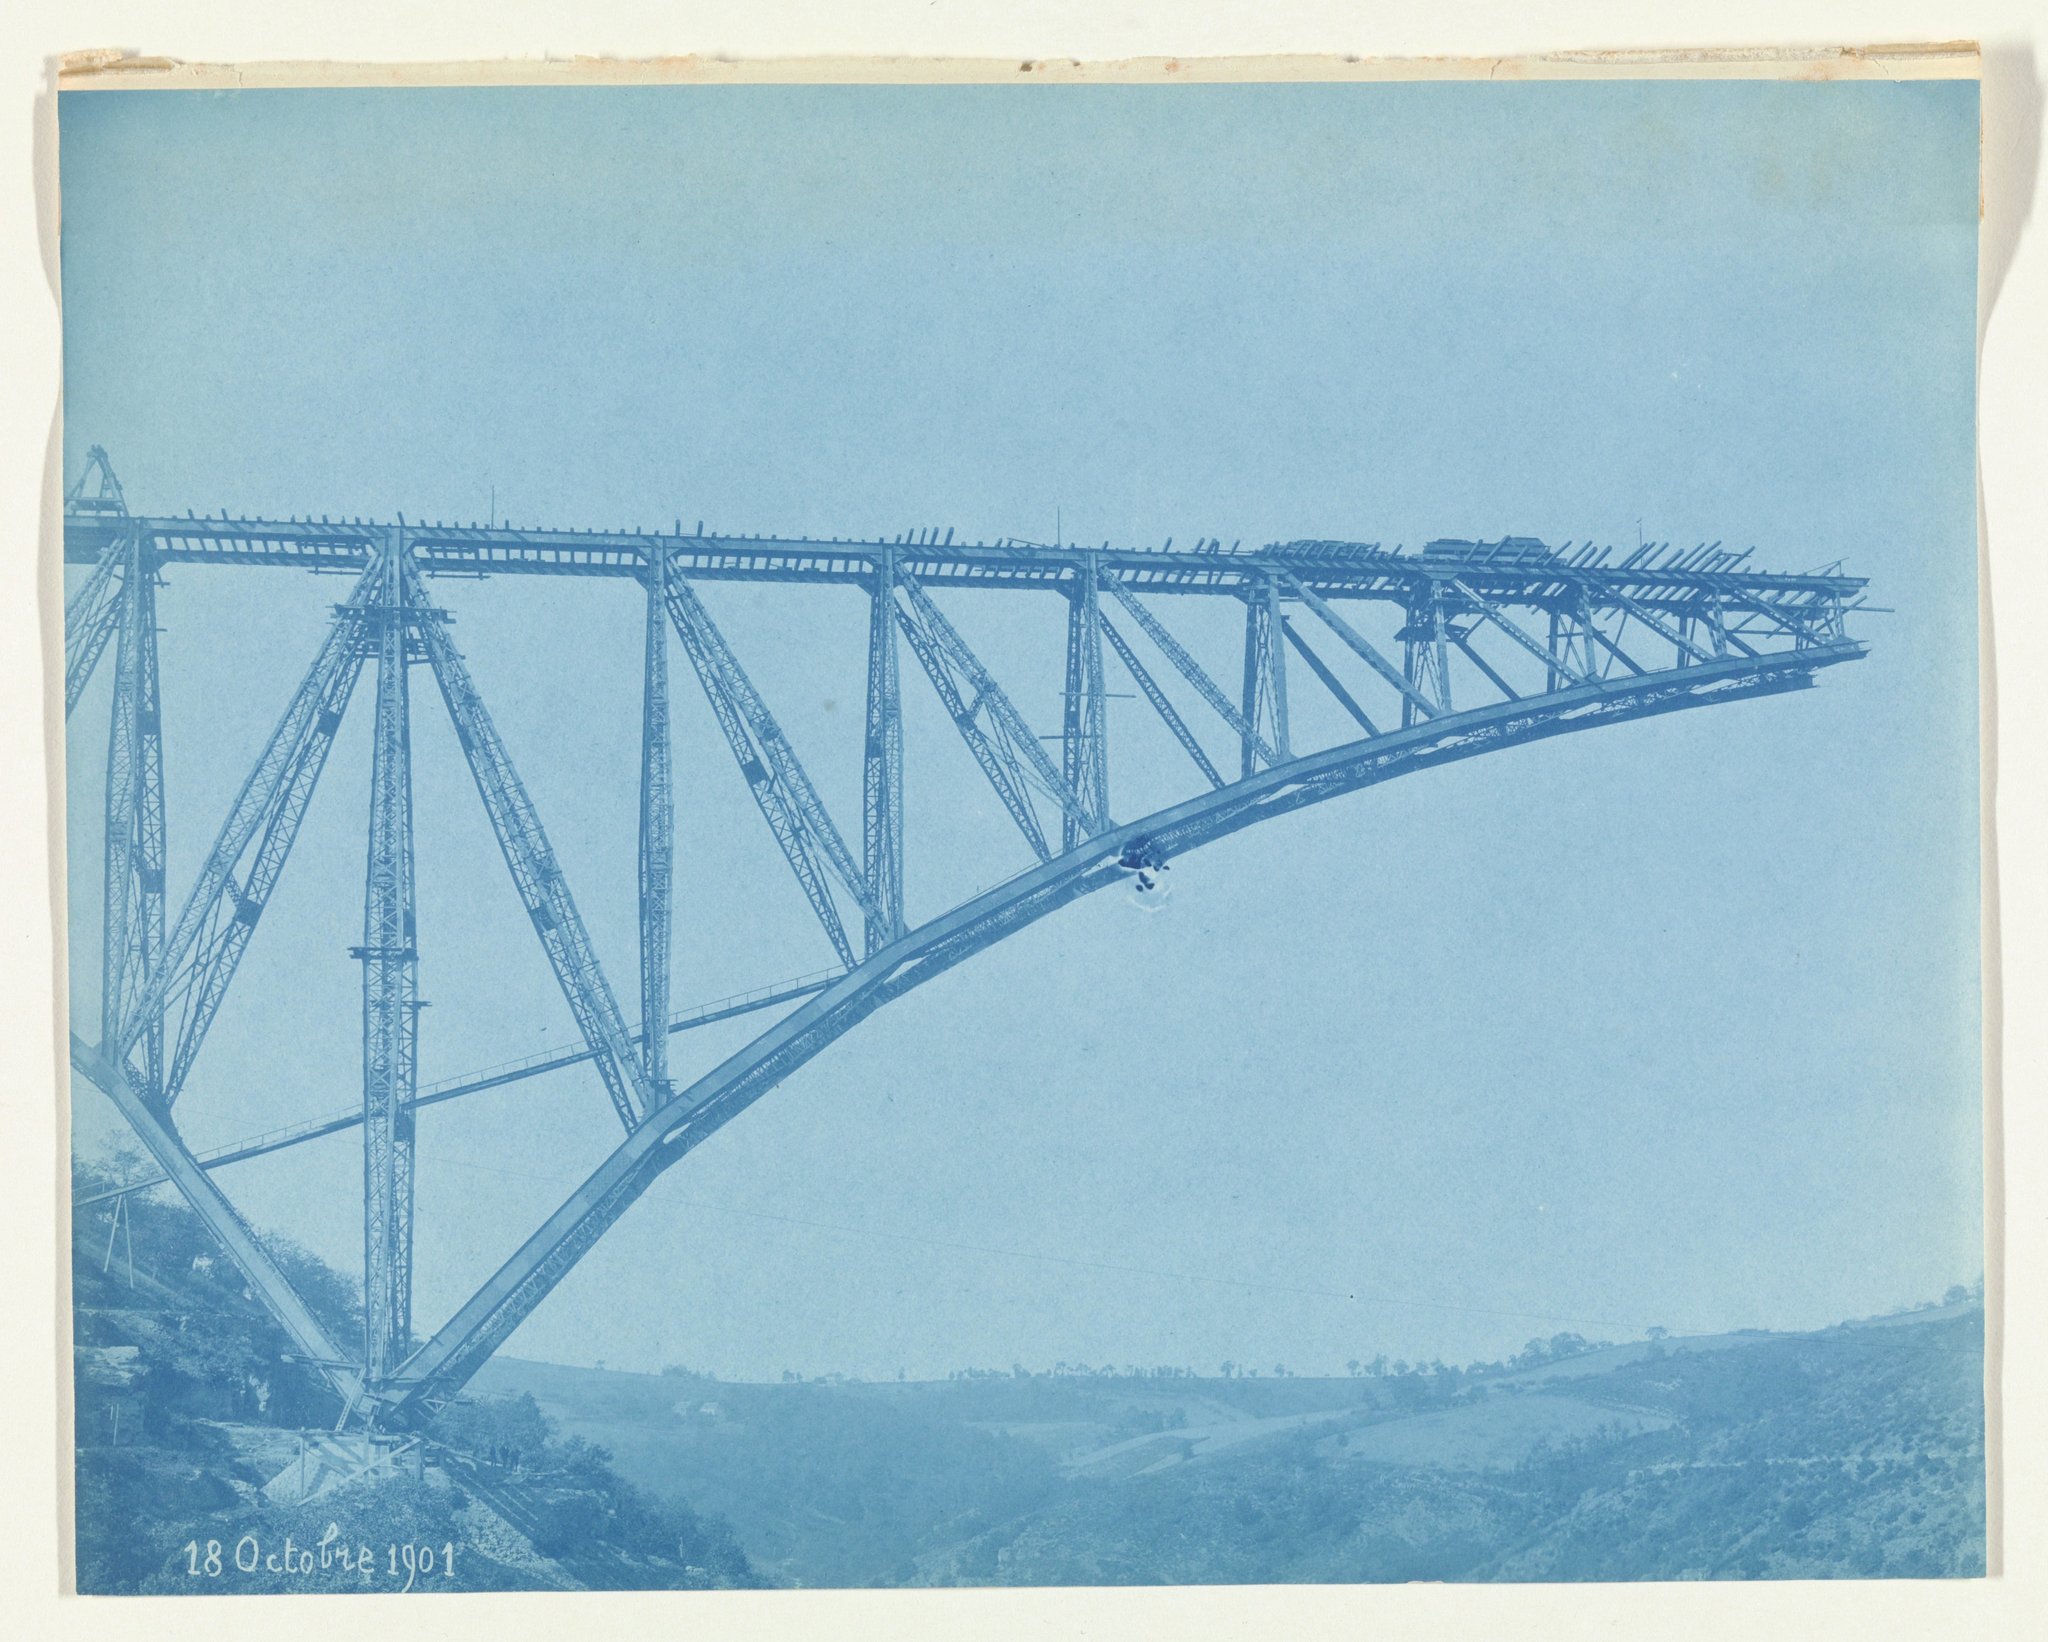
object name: photograph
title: Aanleg van het Viaur Viaduct in Frankrijk door de Societé de Construction des Battignolles, 18 oktober 1901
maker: Anonymous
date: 1901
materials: photographic support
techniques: cyanotype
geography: france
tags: viaduct, making the overground structures (~ building activities)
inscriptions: date